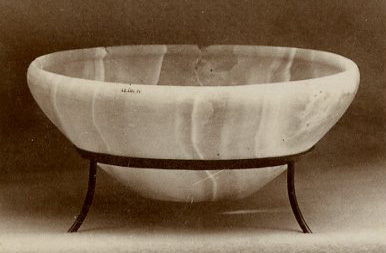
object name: bowl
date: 3100-2649 BCE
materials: stone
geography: egypt